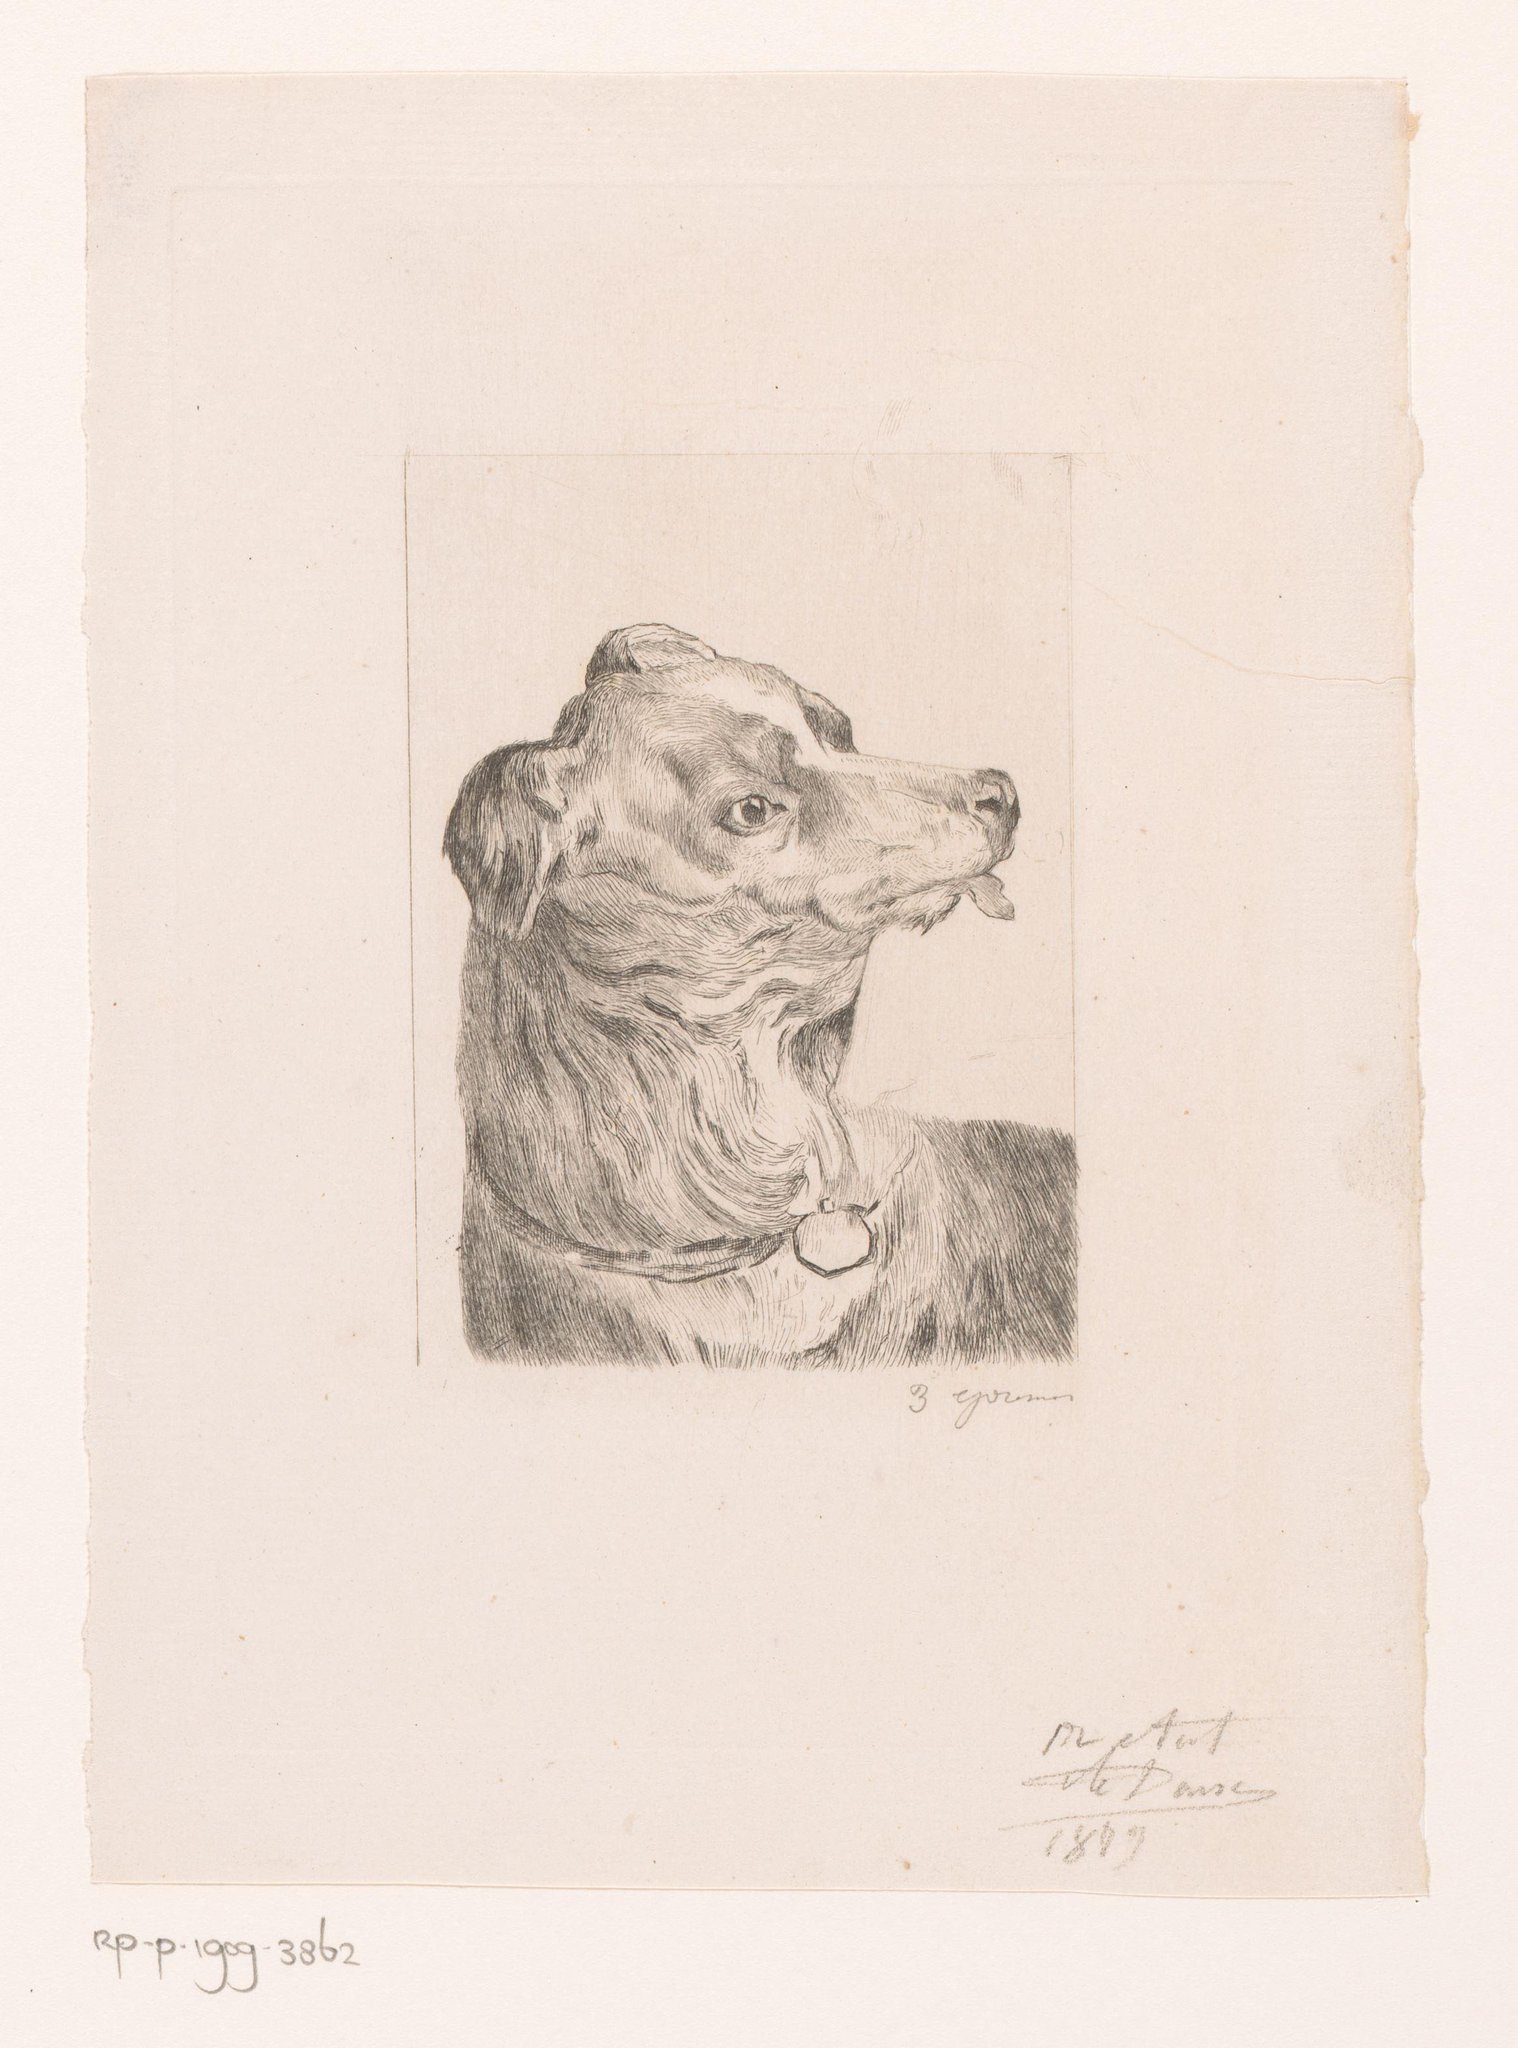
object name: print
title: Kop van een hond met de tong uit de bek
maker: auguste danse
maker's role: print maker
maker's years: 1829-1929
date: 1879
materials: paper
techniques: etching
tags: dog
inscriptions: collector's mark: Lugt 2228, annotation: ‘3 epreuves; 1er etat’